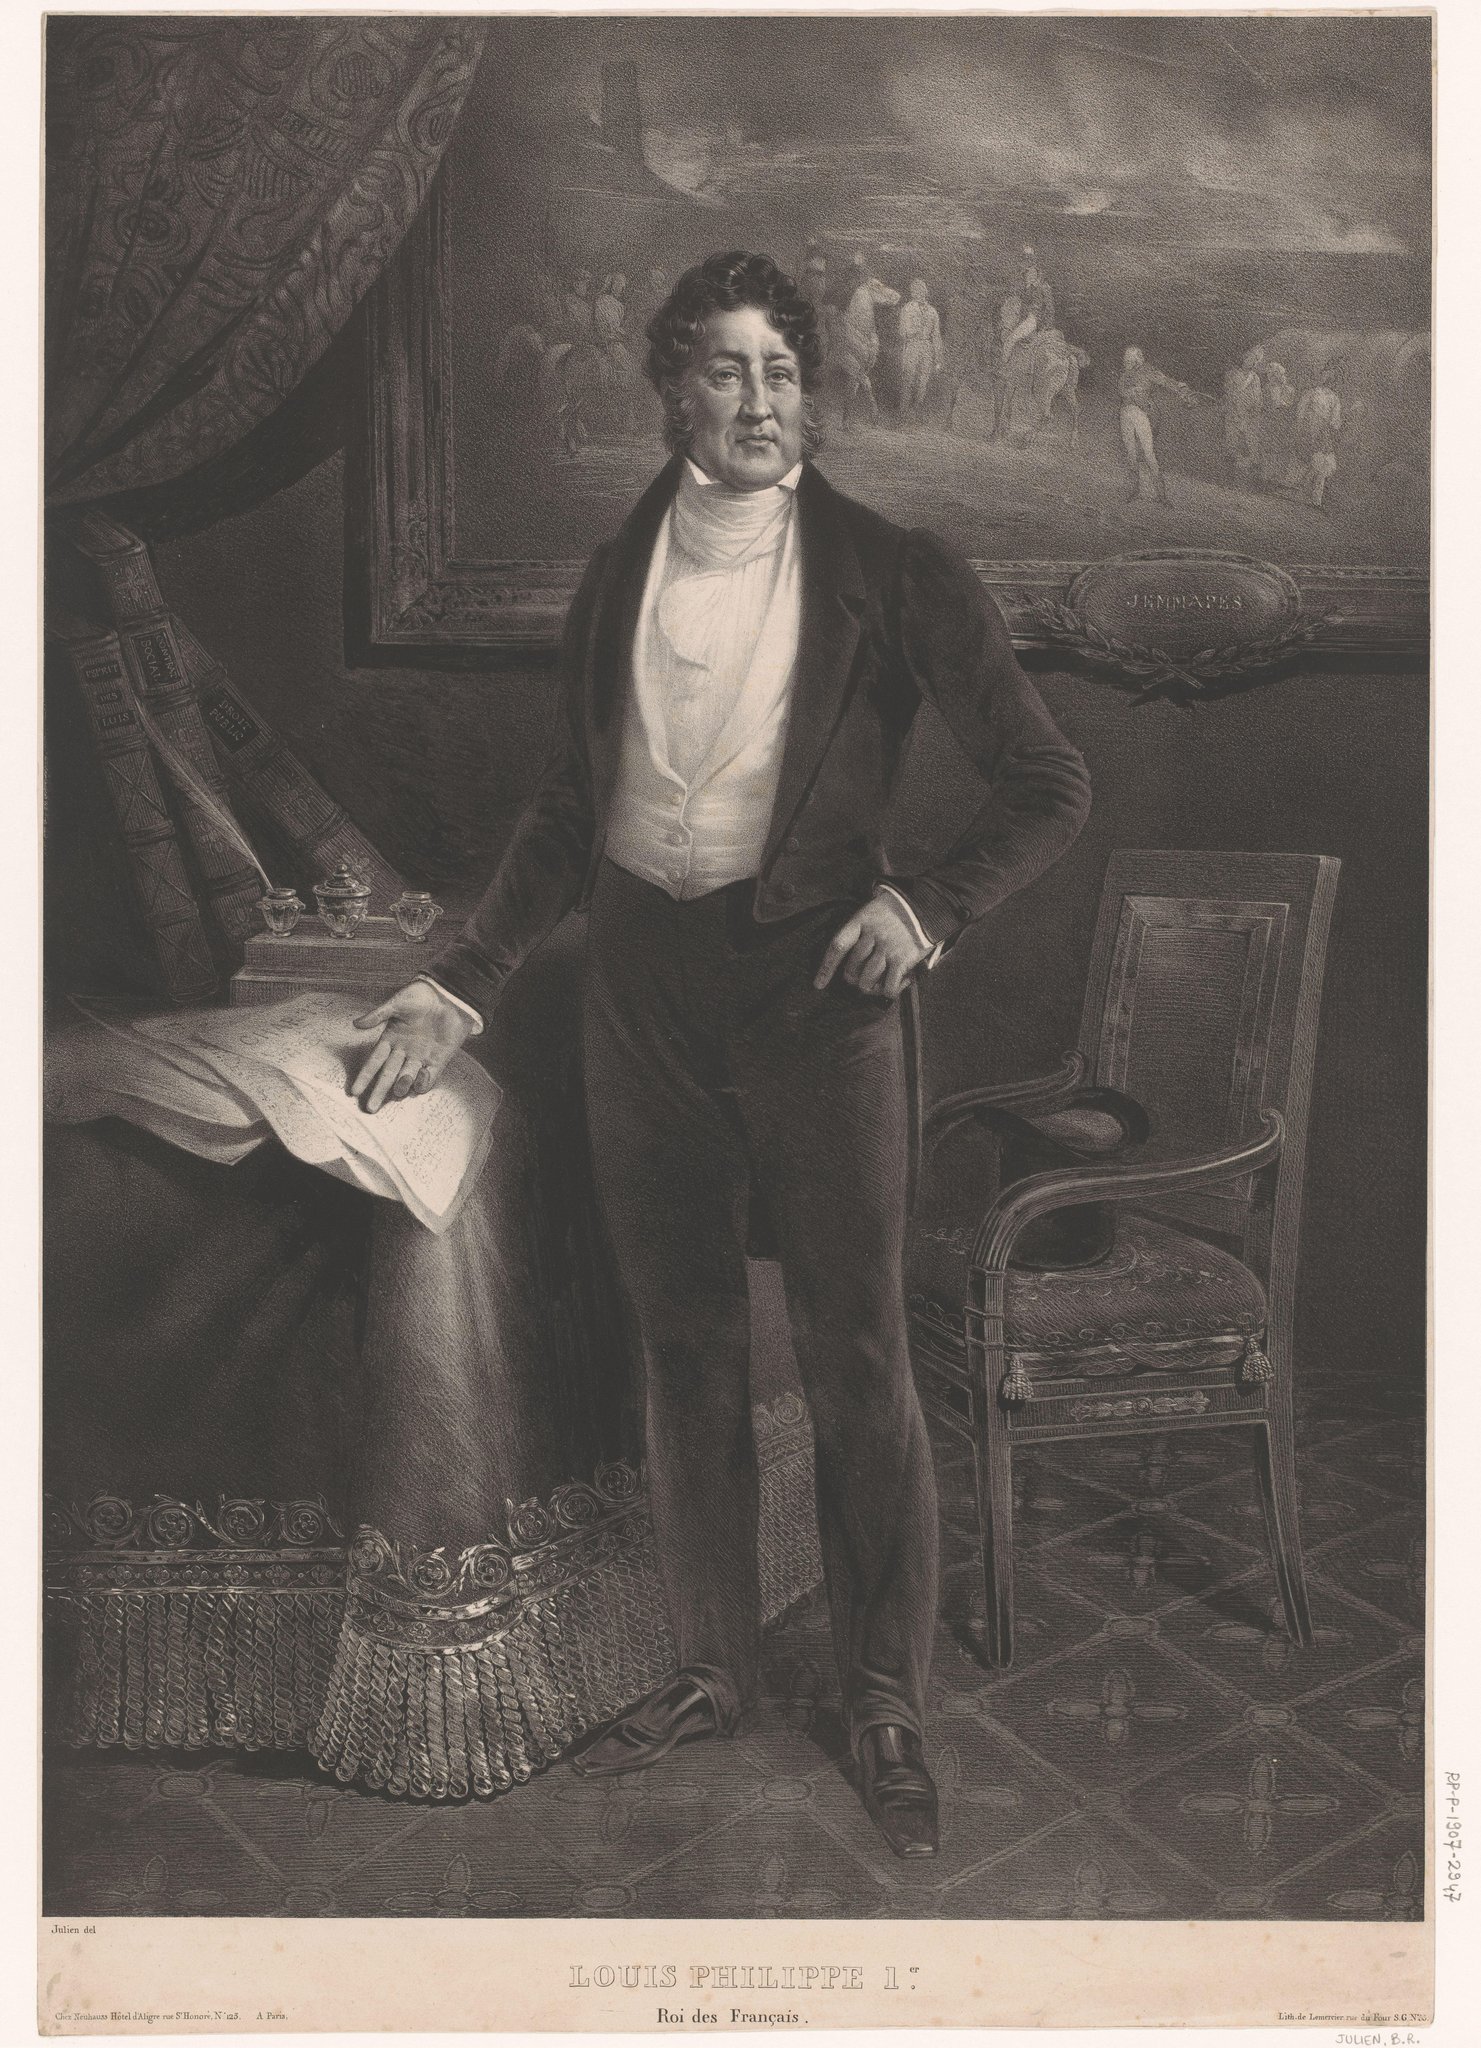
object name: print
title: Portret van Lodewijk Filips I van Frankrijk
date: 1836-1857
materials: paper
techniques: lithograph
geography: paris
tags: paris, lodewijk filips i (koning van frankrijk), historical persons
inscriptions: collector's mark: Lugt 2228a